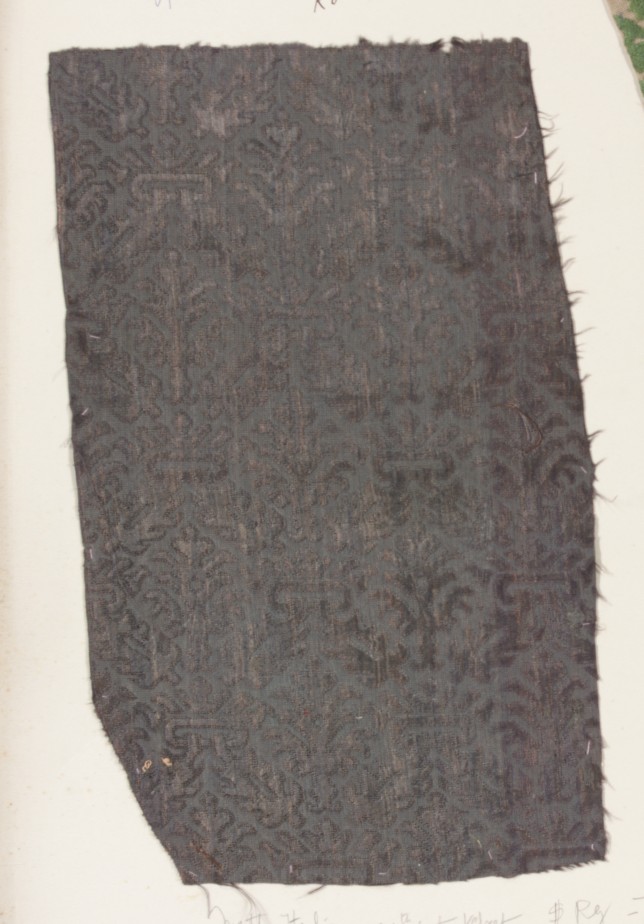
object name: fragment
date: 1501-1600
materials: silk